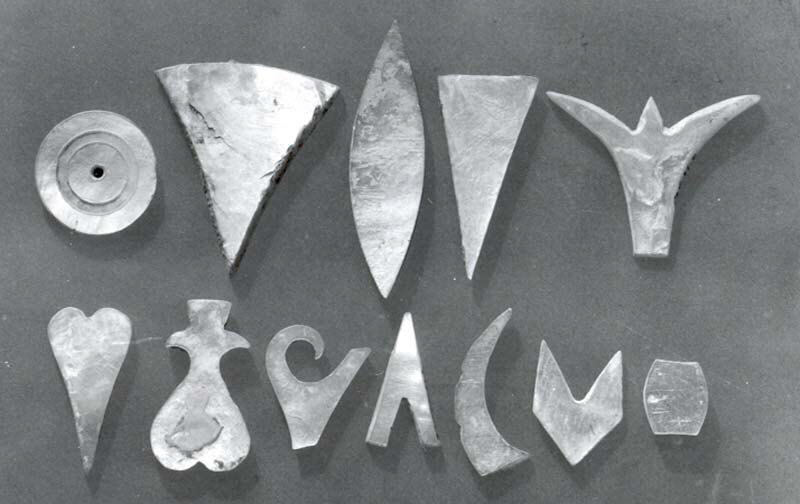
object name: inlay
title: Inlays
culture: sasanian or islamic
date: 601-800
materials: shell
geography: iran